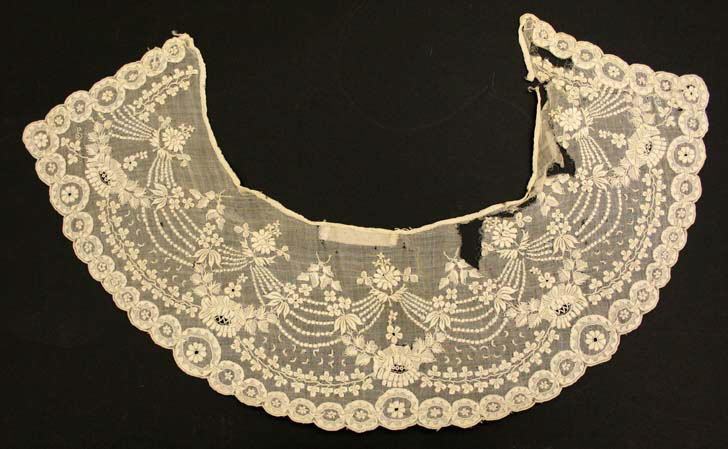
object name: collar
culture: american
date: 1857